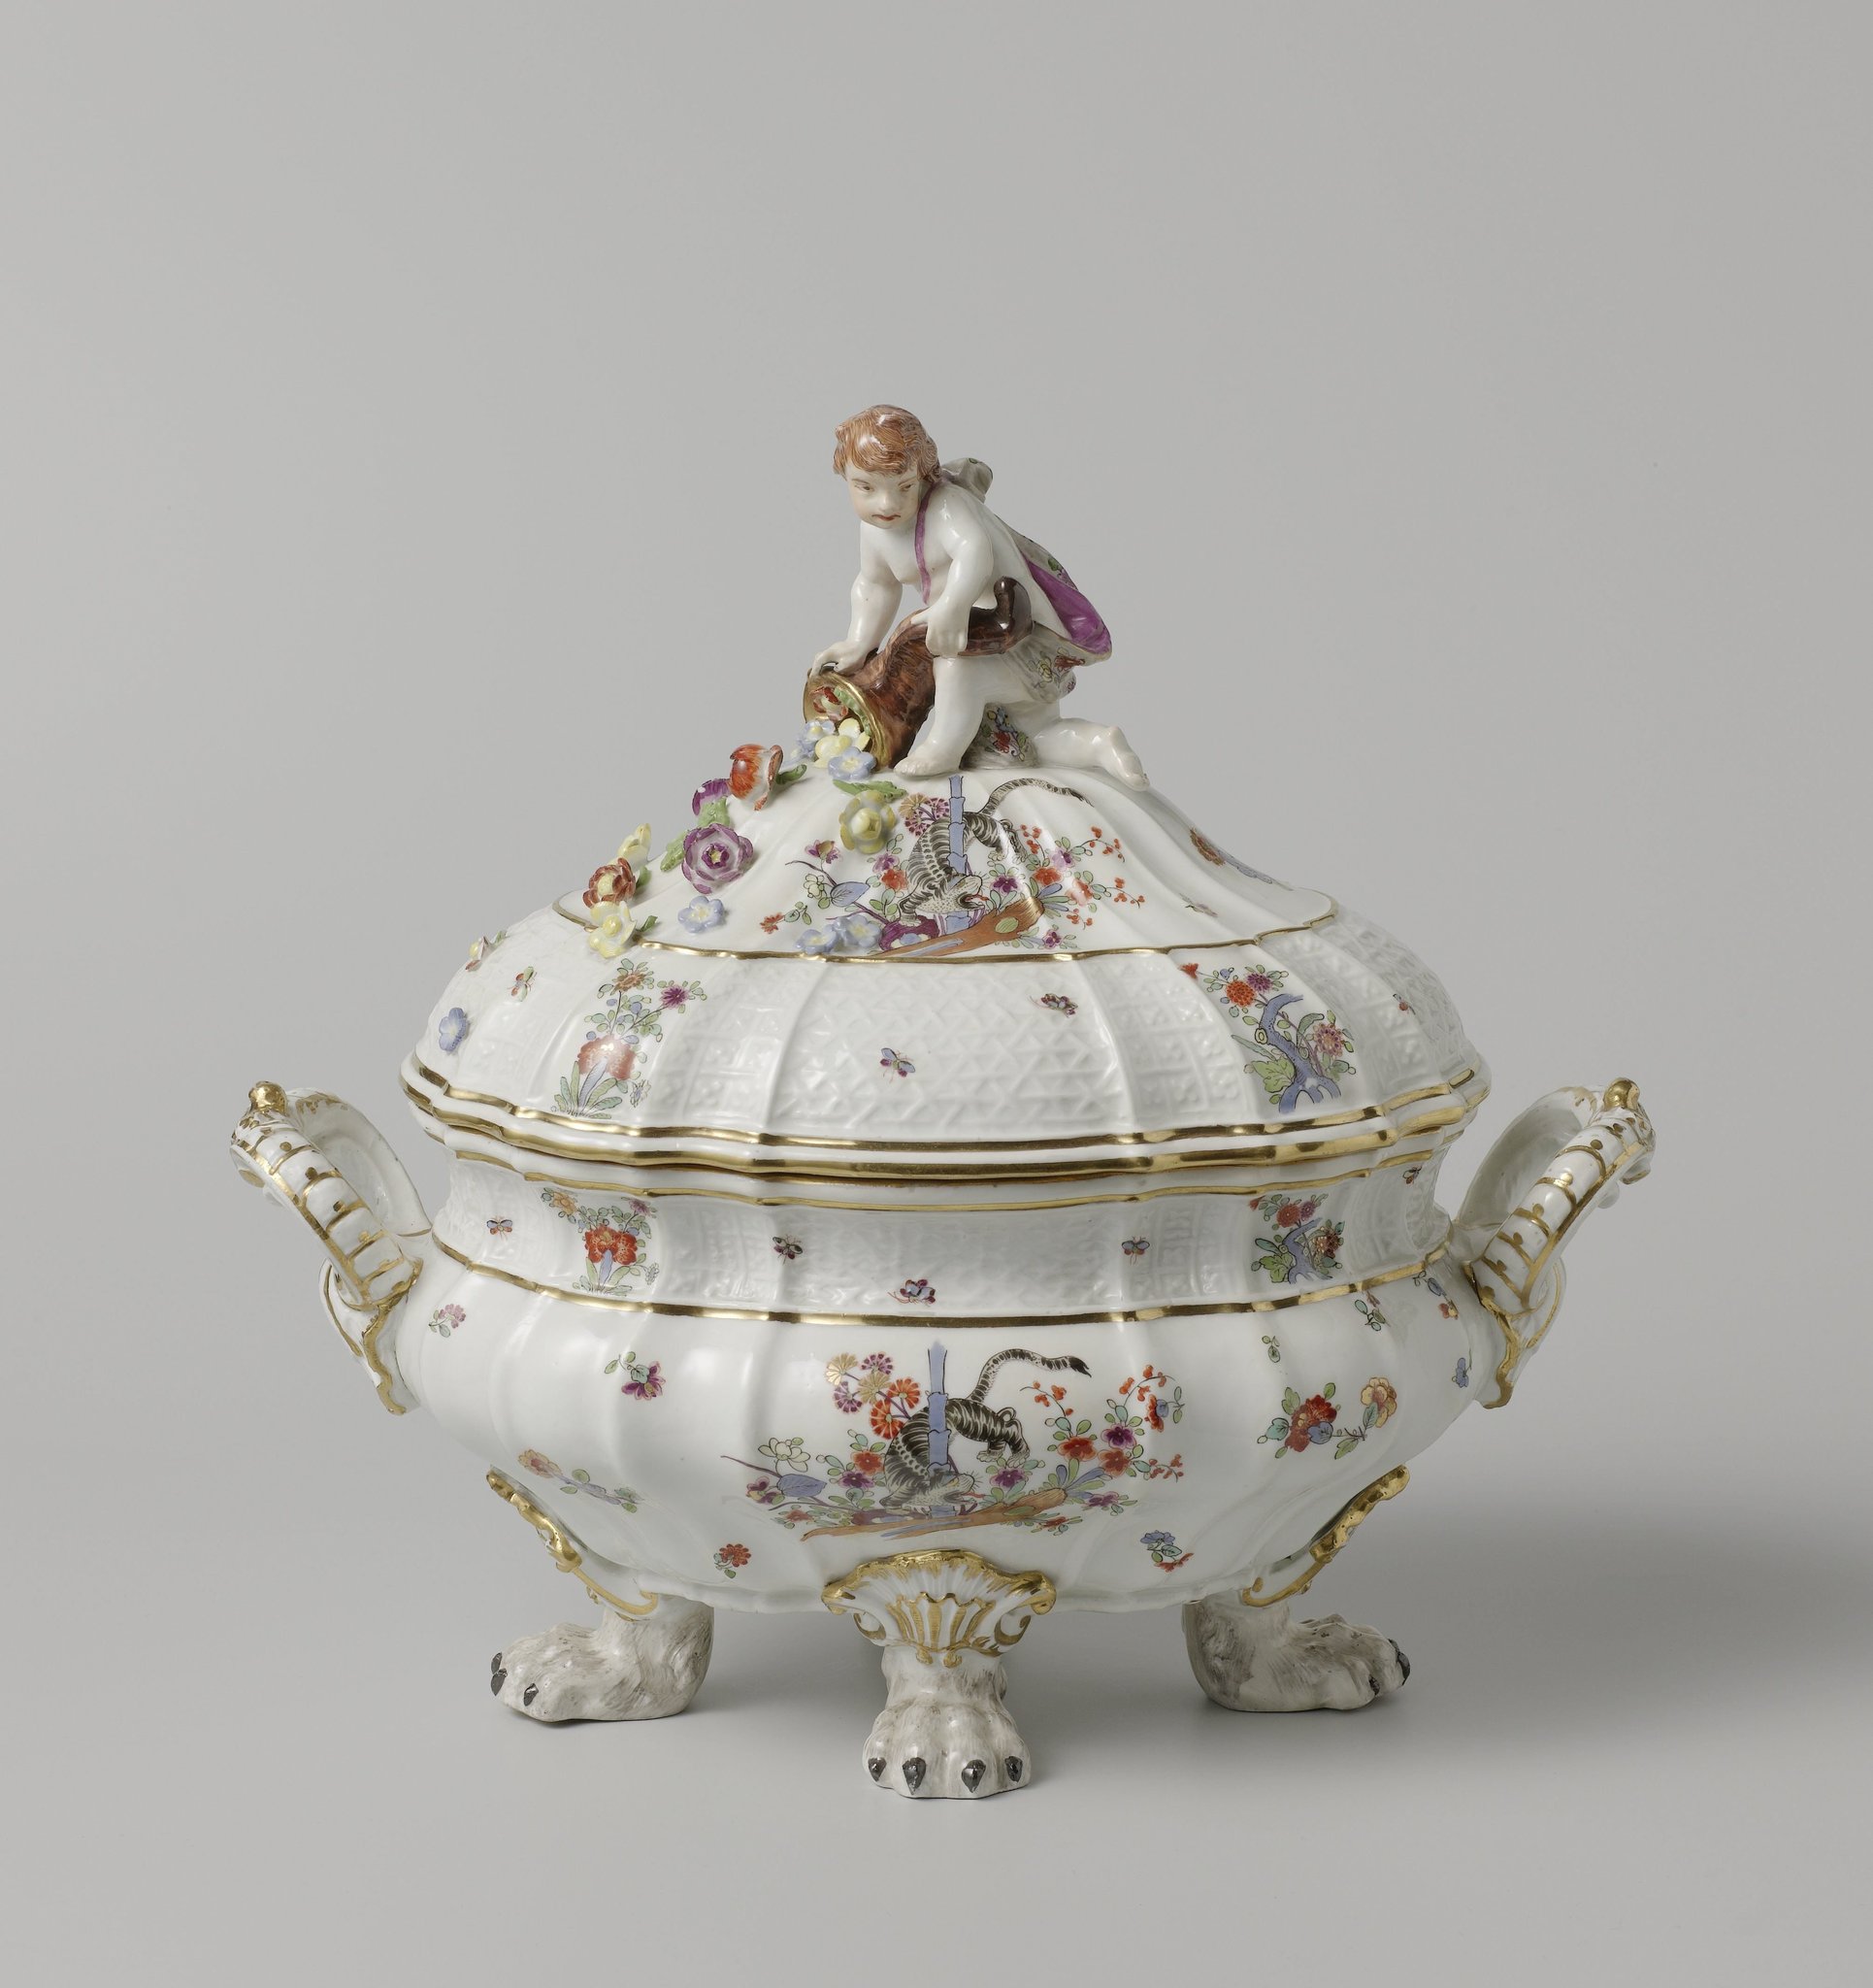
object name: eating drinking utensil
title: Terrine, veelkleurig beschilderd met een Kakiemon-decor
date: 1740-1745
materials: porcelain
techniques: painted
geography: meissen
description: Ovale terrine van beschilderd porselein. De terrine staat op vier grijze klauwpoten waarboven een palmetachtig motief in reliëf. De terrine heeft twee oren. De knop van het deksel bestaat uit een putto met een hoorn des overvloeds waaruit bloemen over het deksel rollen. De terrine en het deksel zijn geribd en beschilderd met een tijger om een bamboestengel en gestrooide Indianische Blumen. De randen zijn versierd met het 'Altbrandenstein'-patroon.